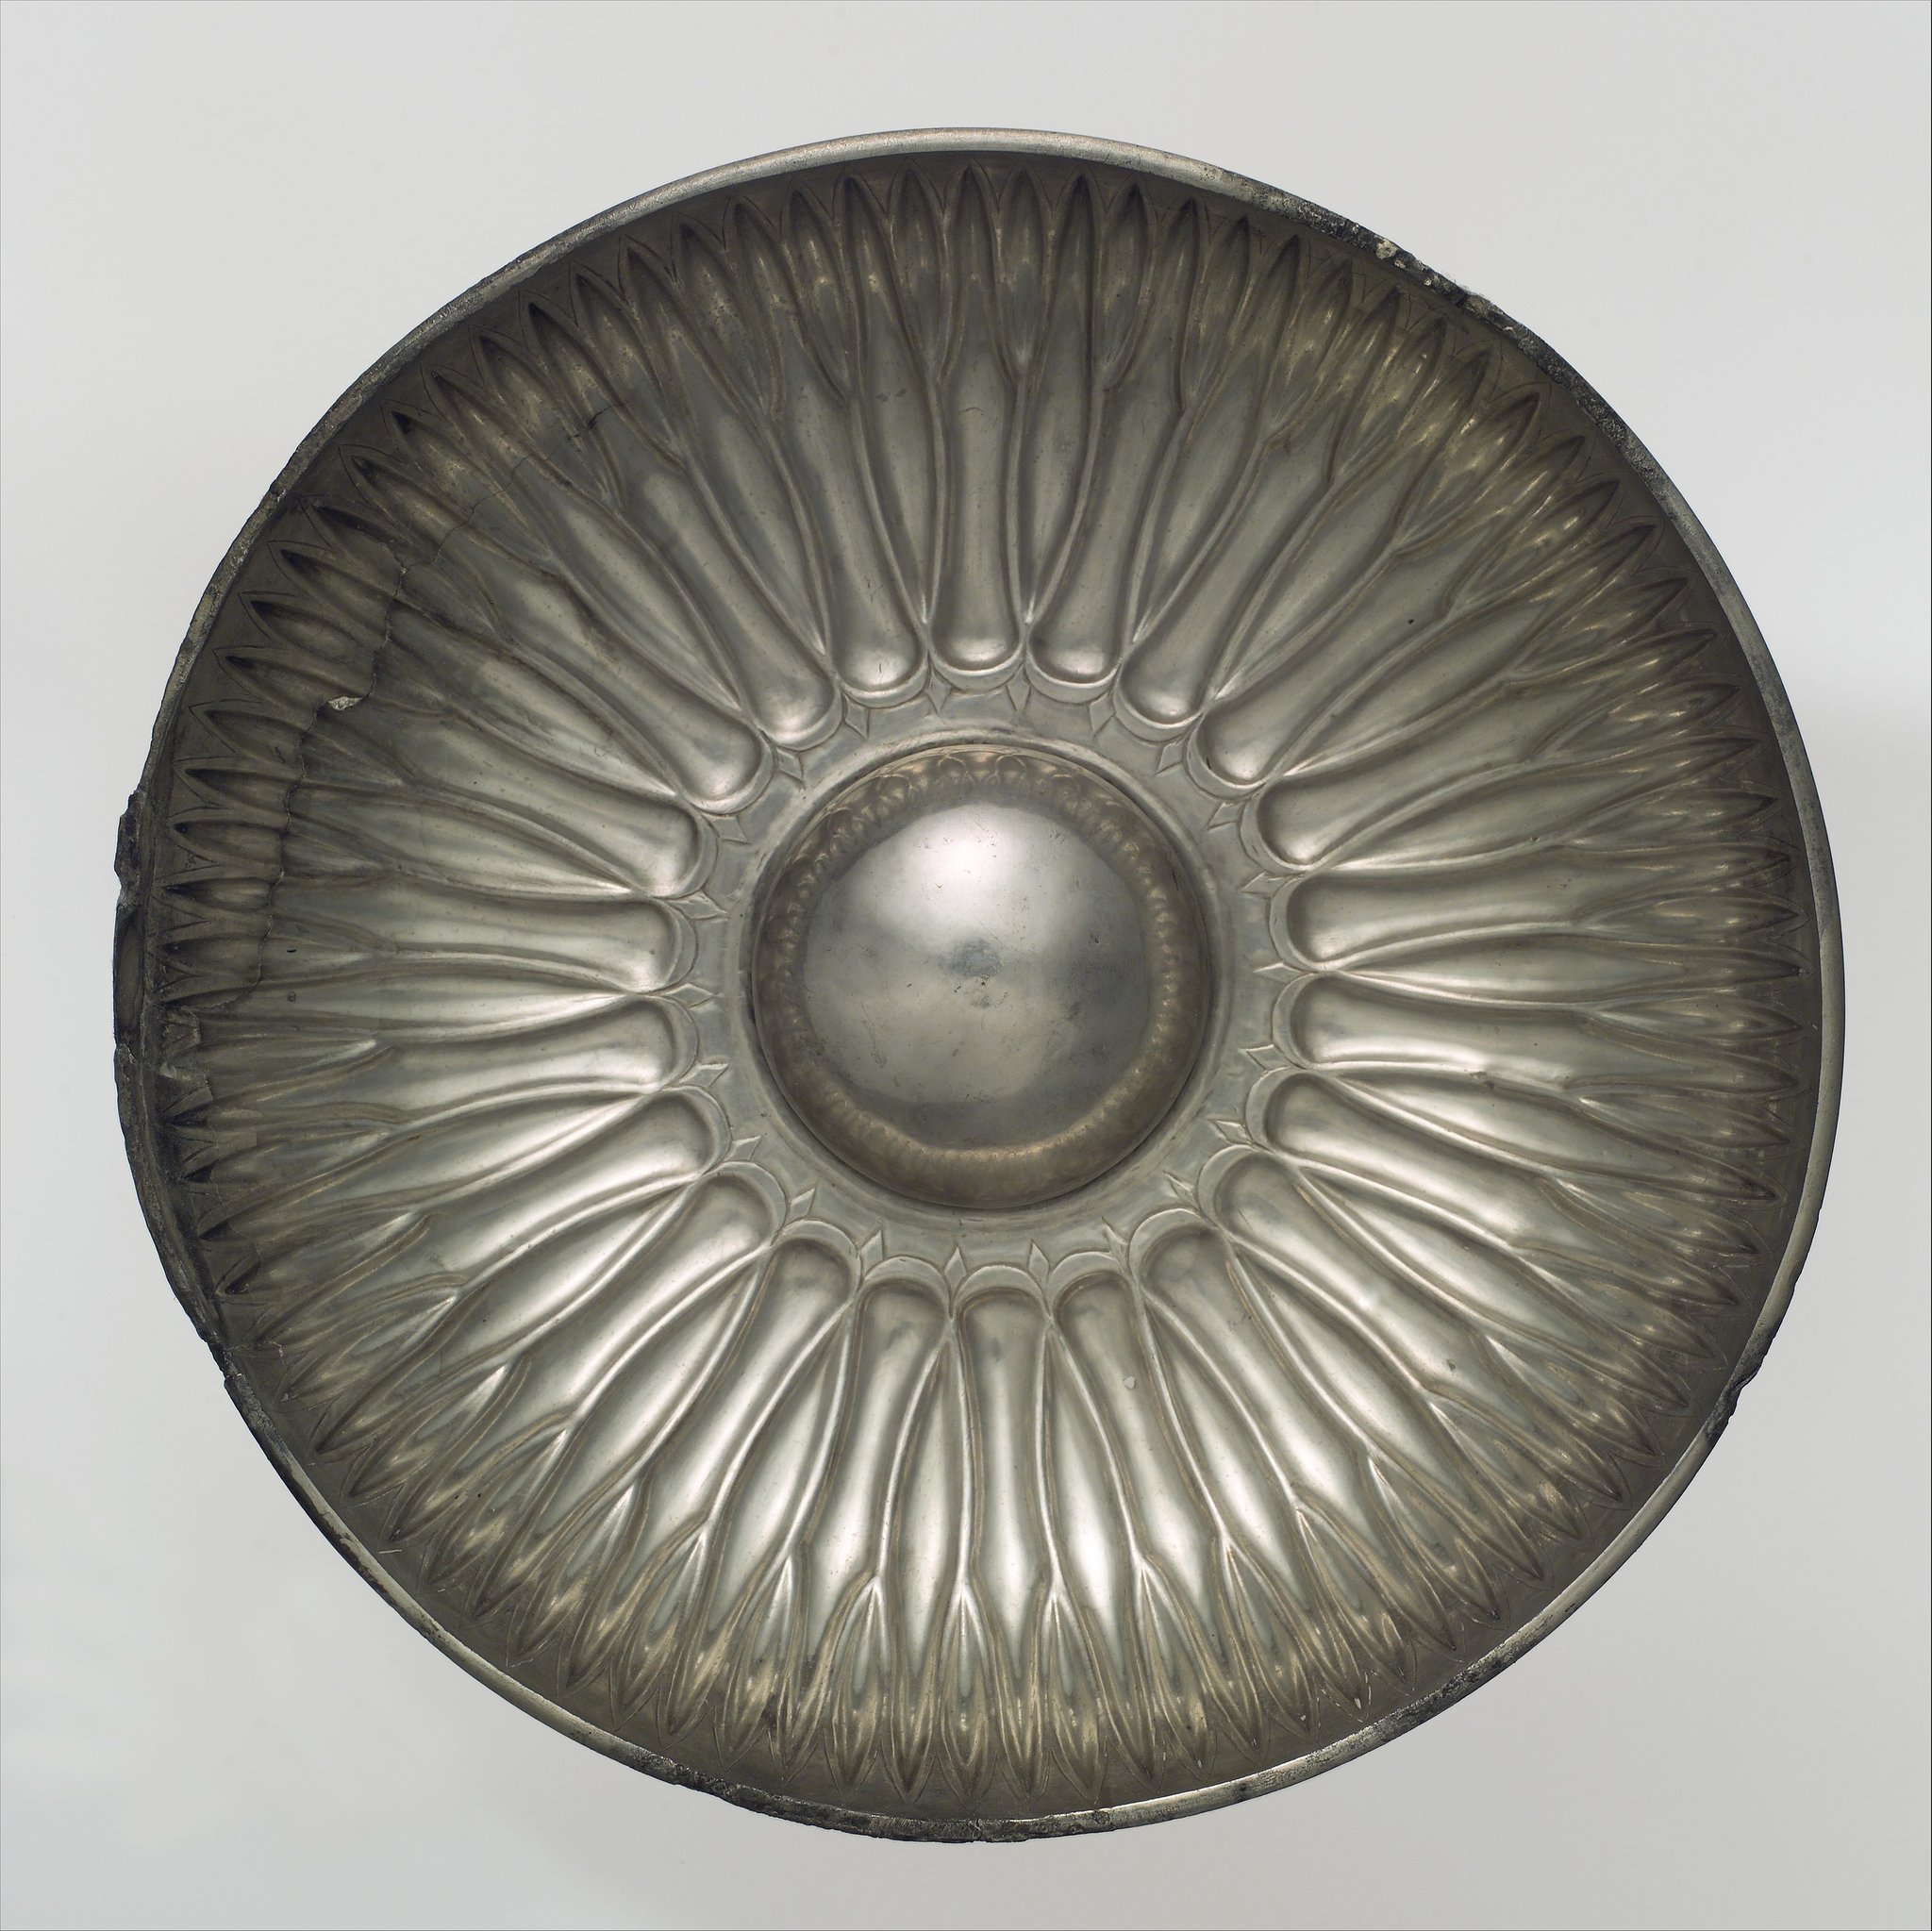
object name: bowl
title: Bowl with a radiating petal design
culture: lydian or phrygian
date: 800-501 BCE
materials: silver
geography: phrygia or lydia